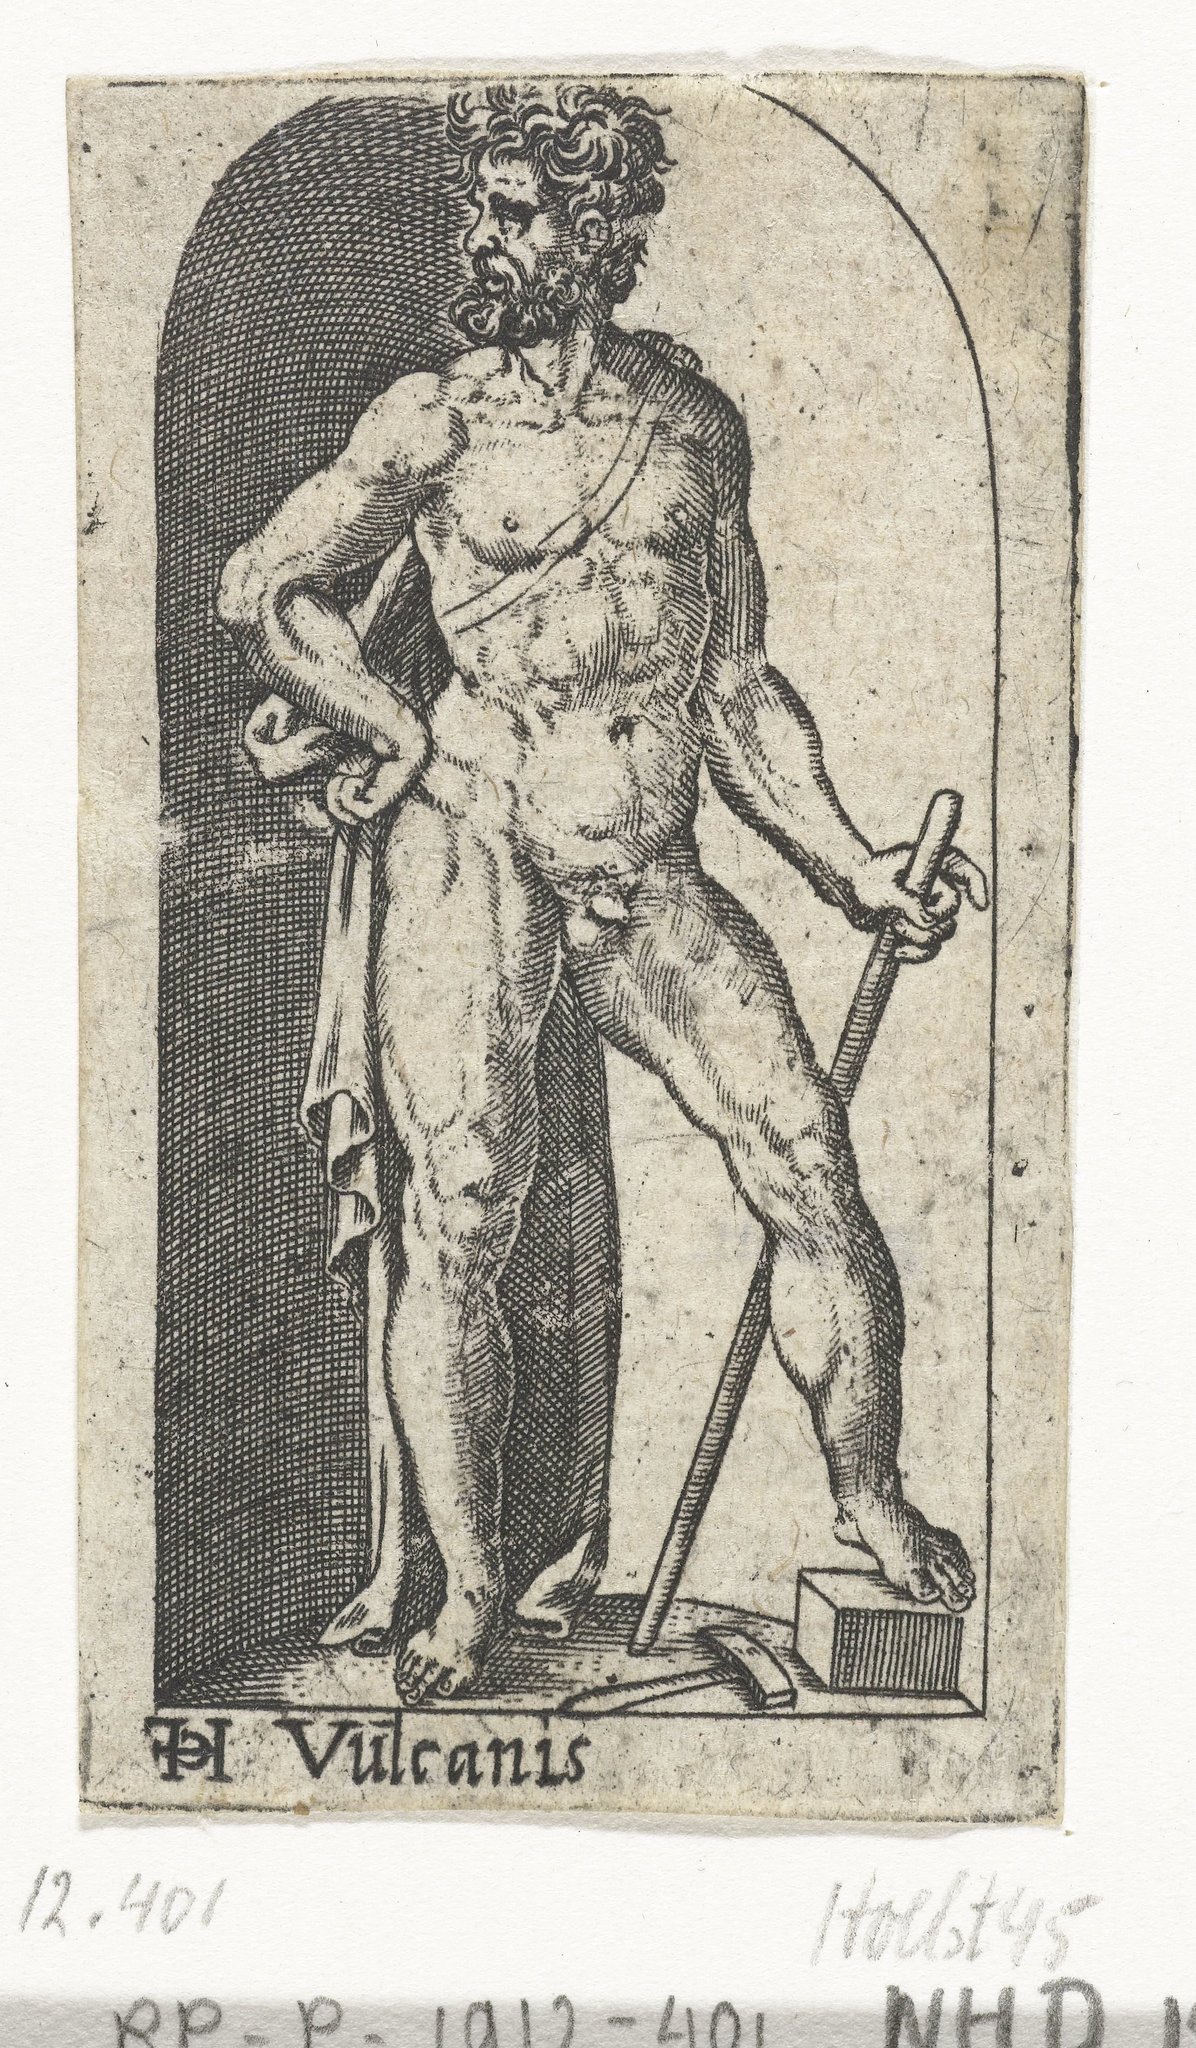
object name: print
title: Vulcanis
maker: hans collaert (i)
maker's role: draughtsman, print maker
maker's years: 1520-1581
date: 1530-1580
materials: paper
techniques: engraving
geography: antwerp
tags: (story of) vulcan (hephaestus)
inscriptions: collector's mark: Lugt 2241, collector's mark: Lugt 2228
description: Vulcanus, de god van het vuur en de smederij, in een nis. In zijn handen een staf. Naast hem op de grond ligt een hamer. De prent is deel van een serie met ontwerpen van bekende personen uit de Bijbel, de mythologie en de Oudheid als onderwerp.